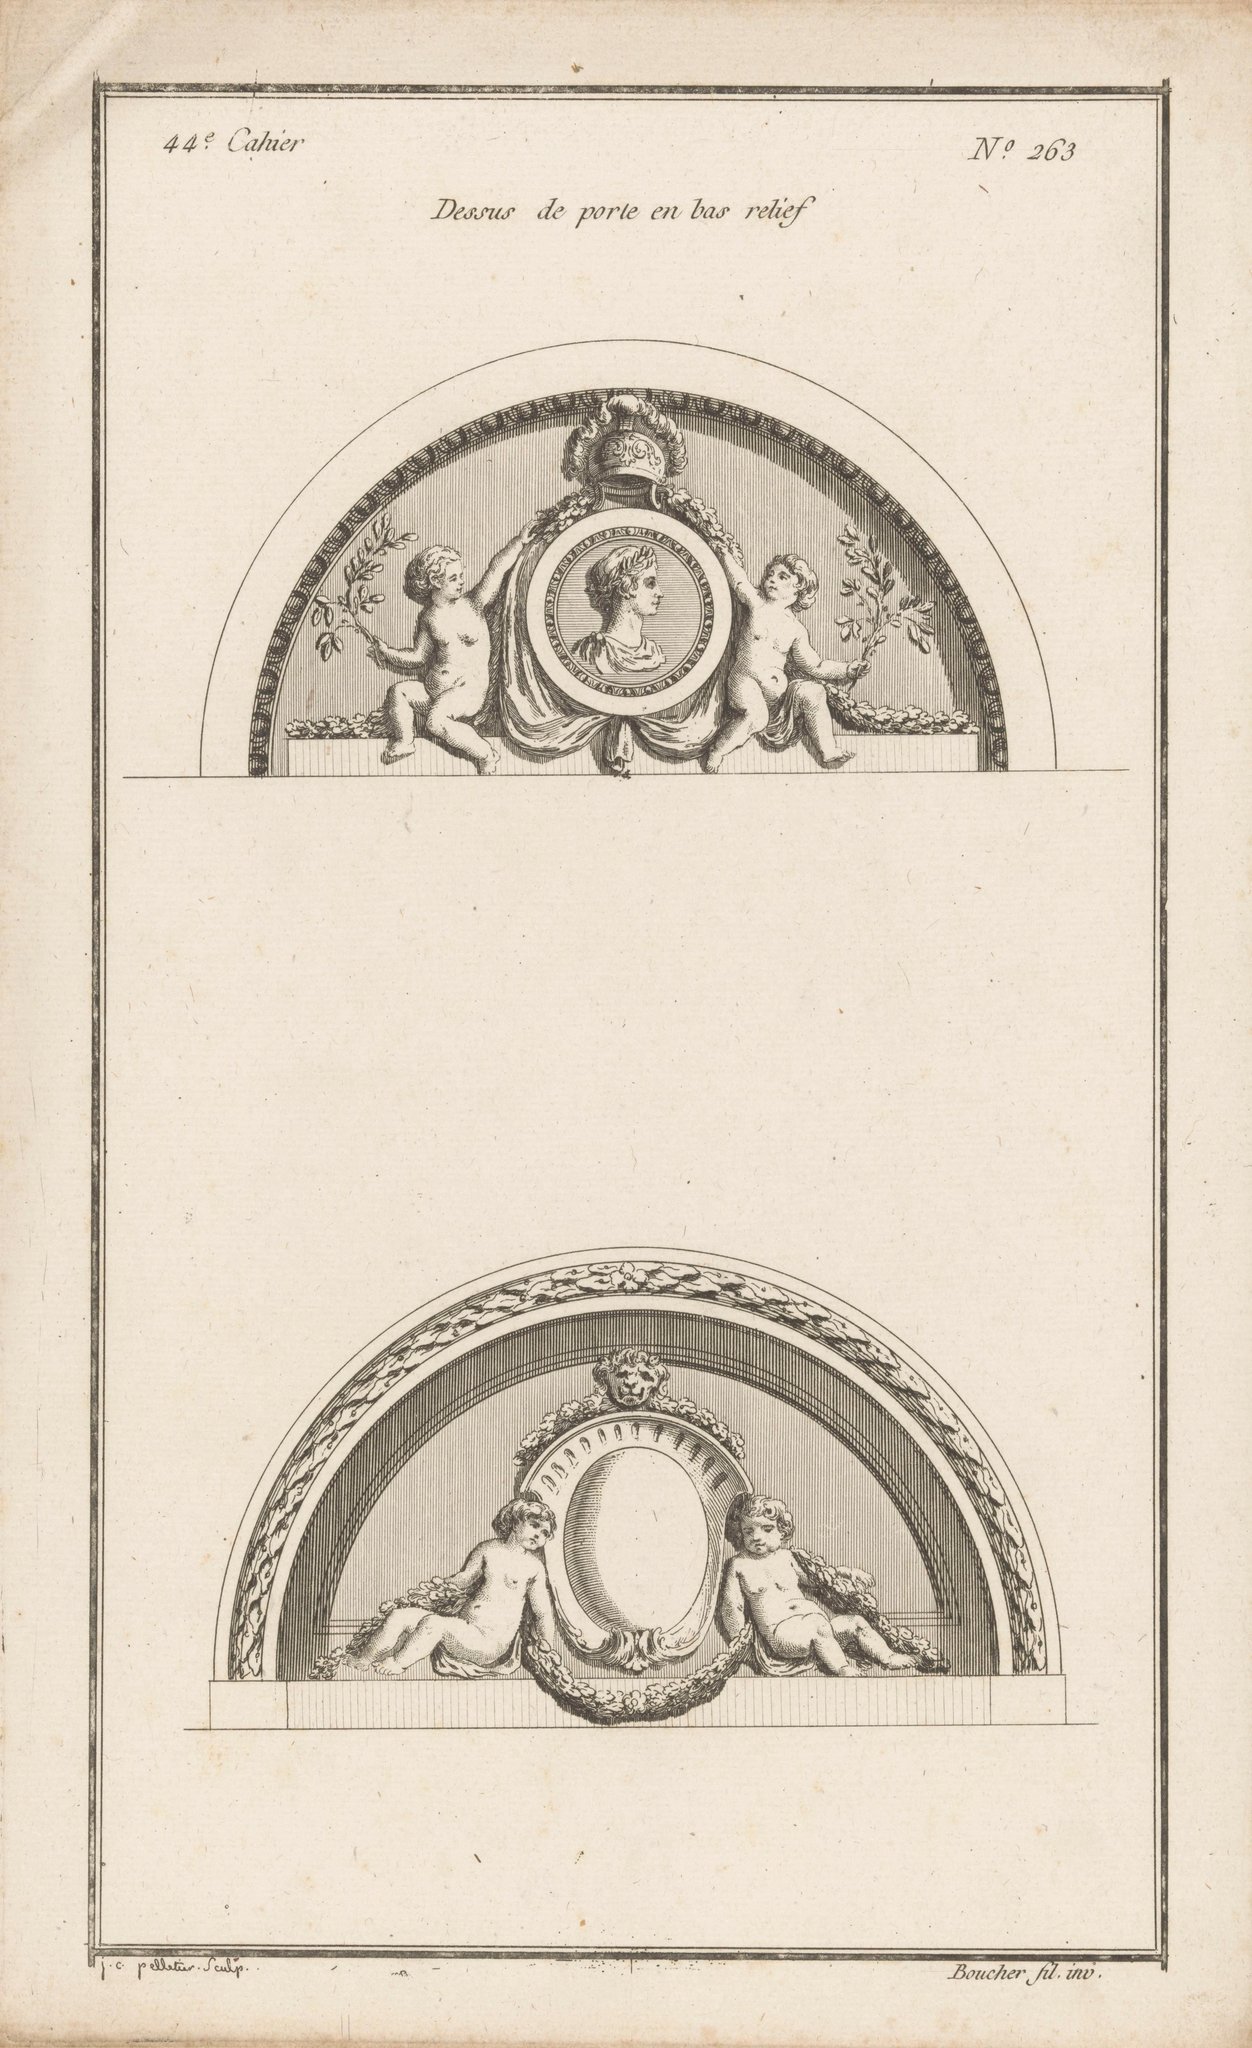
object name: print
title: Medaillon en cartouche met putti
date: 1772-1779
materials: paper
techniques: engraving, etching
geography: paris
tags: ornament ~ medallion, ornament ~ cartouche, cupids: 'amores', 'amoretti', 'putti'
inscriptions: collector's mark: Lugt 2228, collector's mark: Lugt 2760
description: Twee halfronde dessus-de-portes. Boven met twee putti aan weerszijden van een portret en profil in een rond medaillon met helm, onder met twee putti aan weerszijden van een cartouche met leeuwenkop. Prentnummer 263.